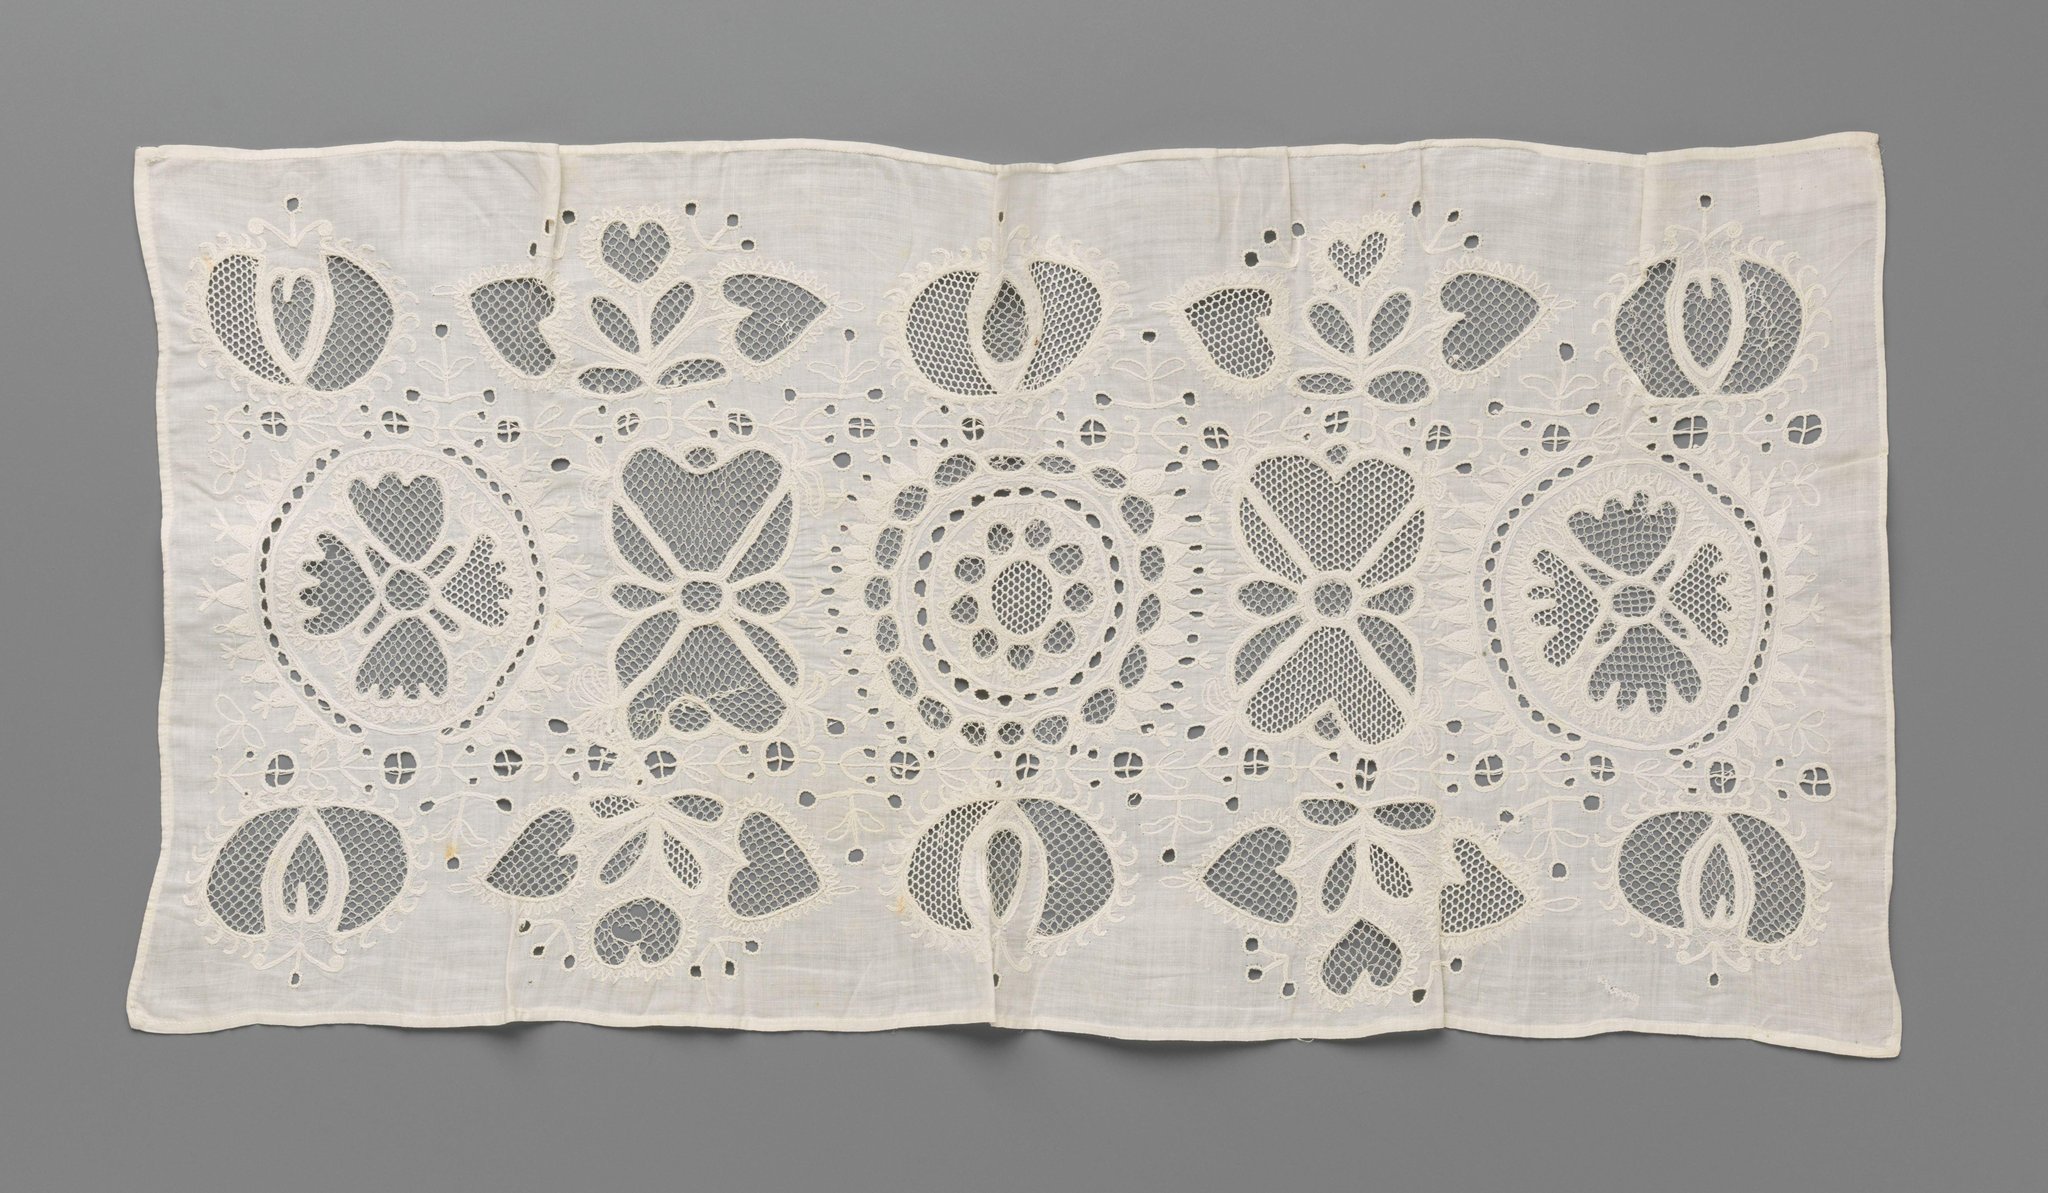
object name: curtain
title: Gordijnstrook van katoen met kloskant-traliegronden in grote opengewerkte motieven waar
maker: Anonymous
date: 1900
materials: cotton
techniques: lace, embroidered, stitch, weave, embroidery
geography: hungary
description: Gordijnstrook van naturelkleurig katoen met grote opengewerkte motieven met inzetten van twee verschillende soorten traliegronden (kloskant). Om de motieven heen zijn versieringen aangebracht met borduurwerk: witwerk. De motieven zijn in drie rijen en vijf kolommen gerangschikt met de grootste motieven in de middelste rij. De motieven zijn onder andere cirkelvormig, hartvormig, vlindervormig en halve maanvormig. De strook is rechthoekig van vorm en aan alle zijden afgewerkt met een smal zoompje.